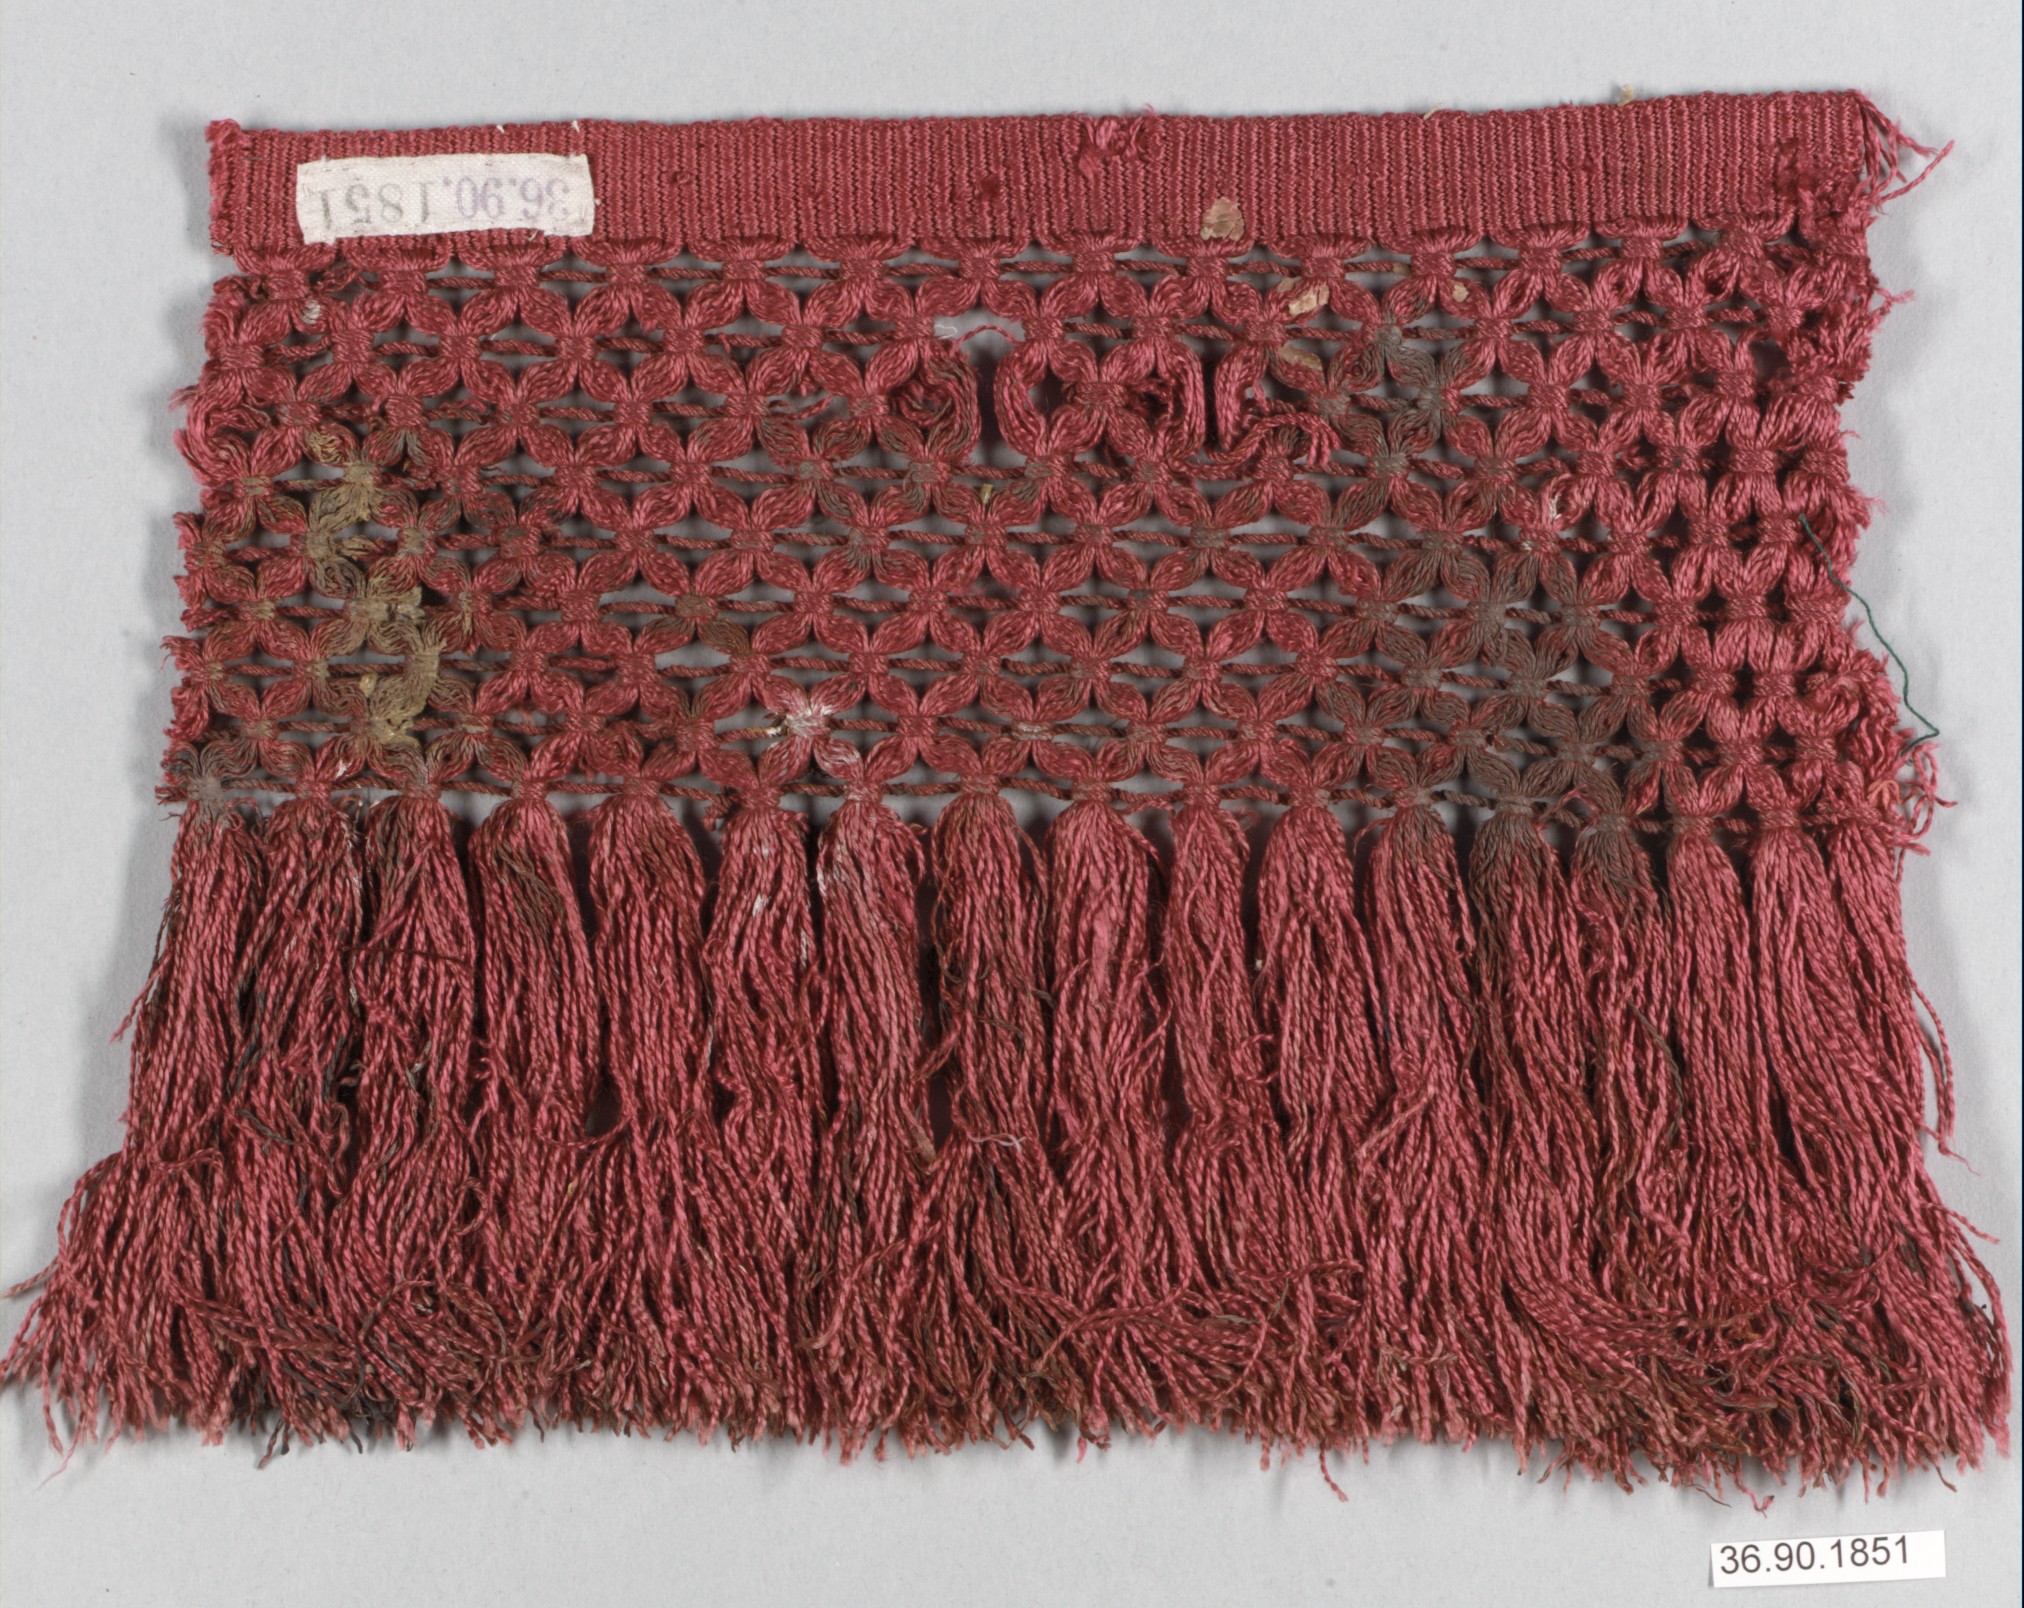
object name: fringe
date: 1701-1800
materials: silk